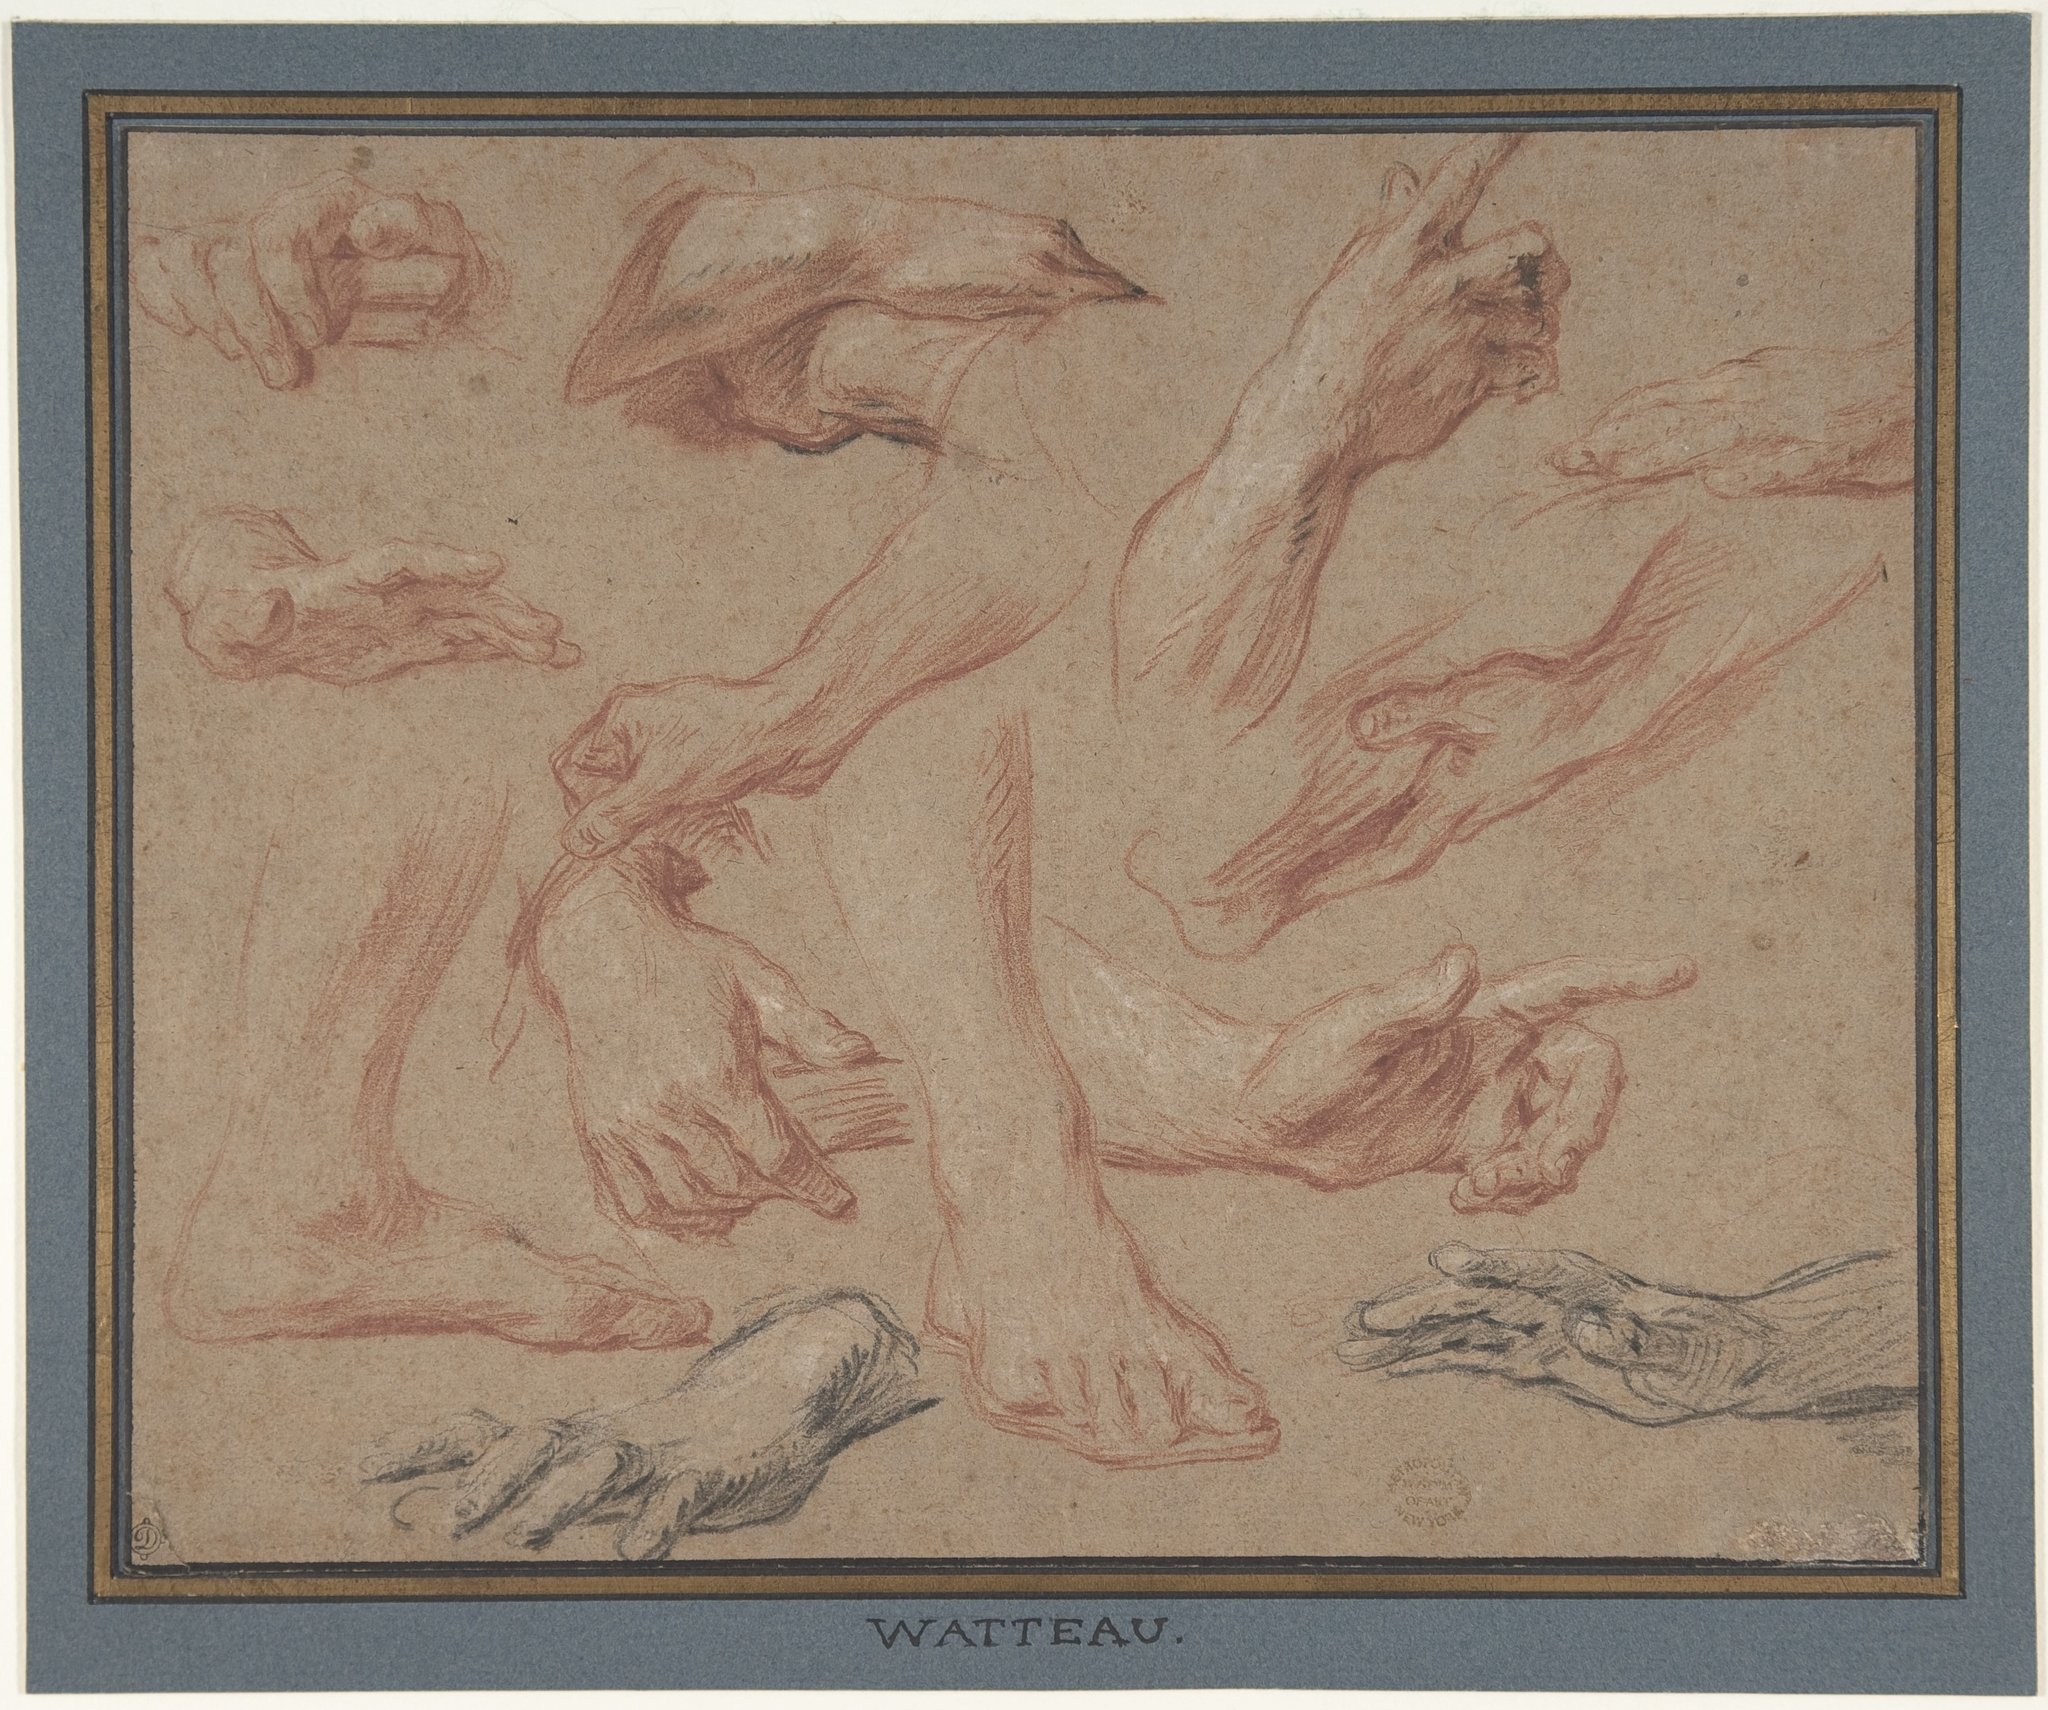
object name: drawing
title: Studies of Hands and Feet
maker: françois le moyne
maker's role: artist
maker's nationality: french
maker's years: 1688-1737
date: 1701-1733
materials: chalk, ink, paper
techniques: heightening, pen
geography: france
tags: feet,hands